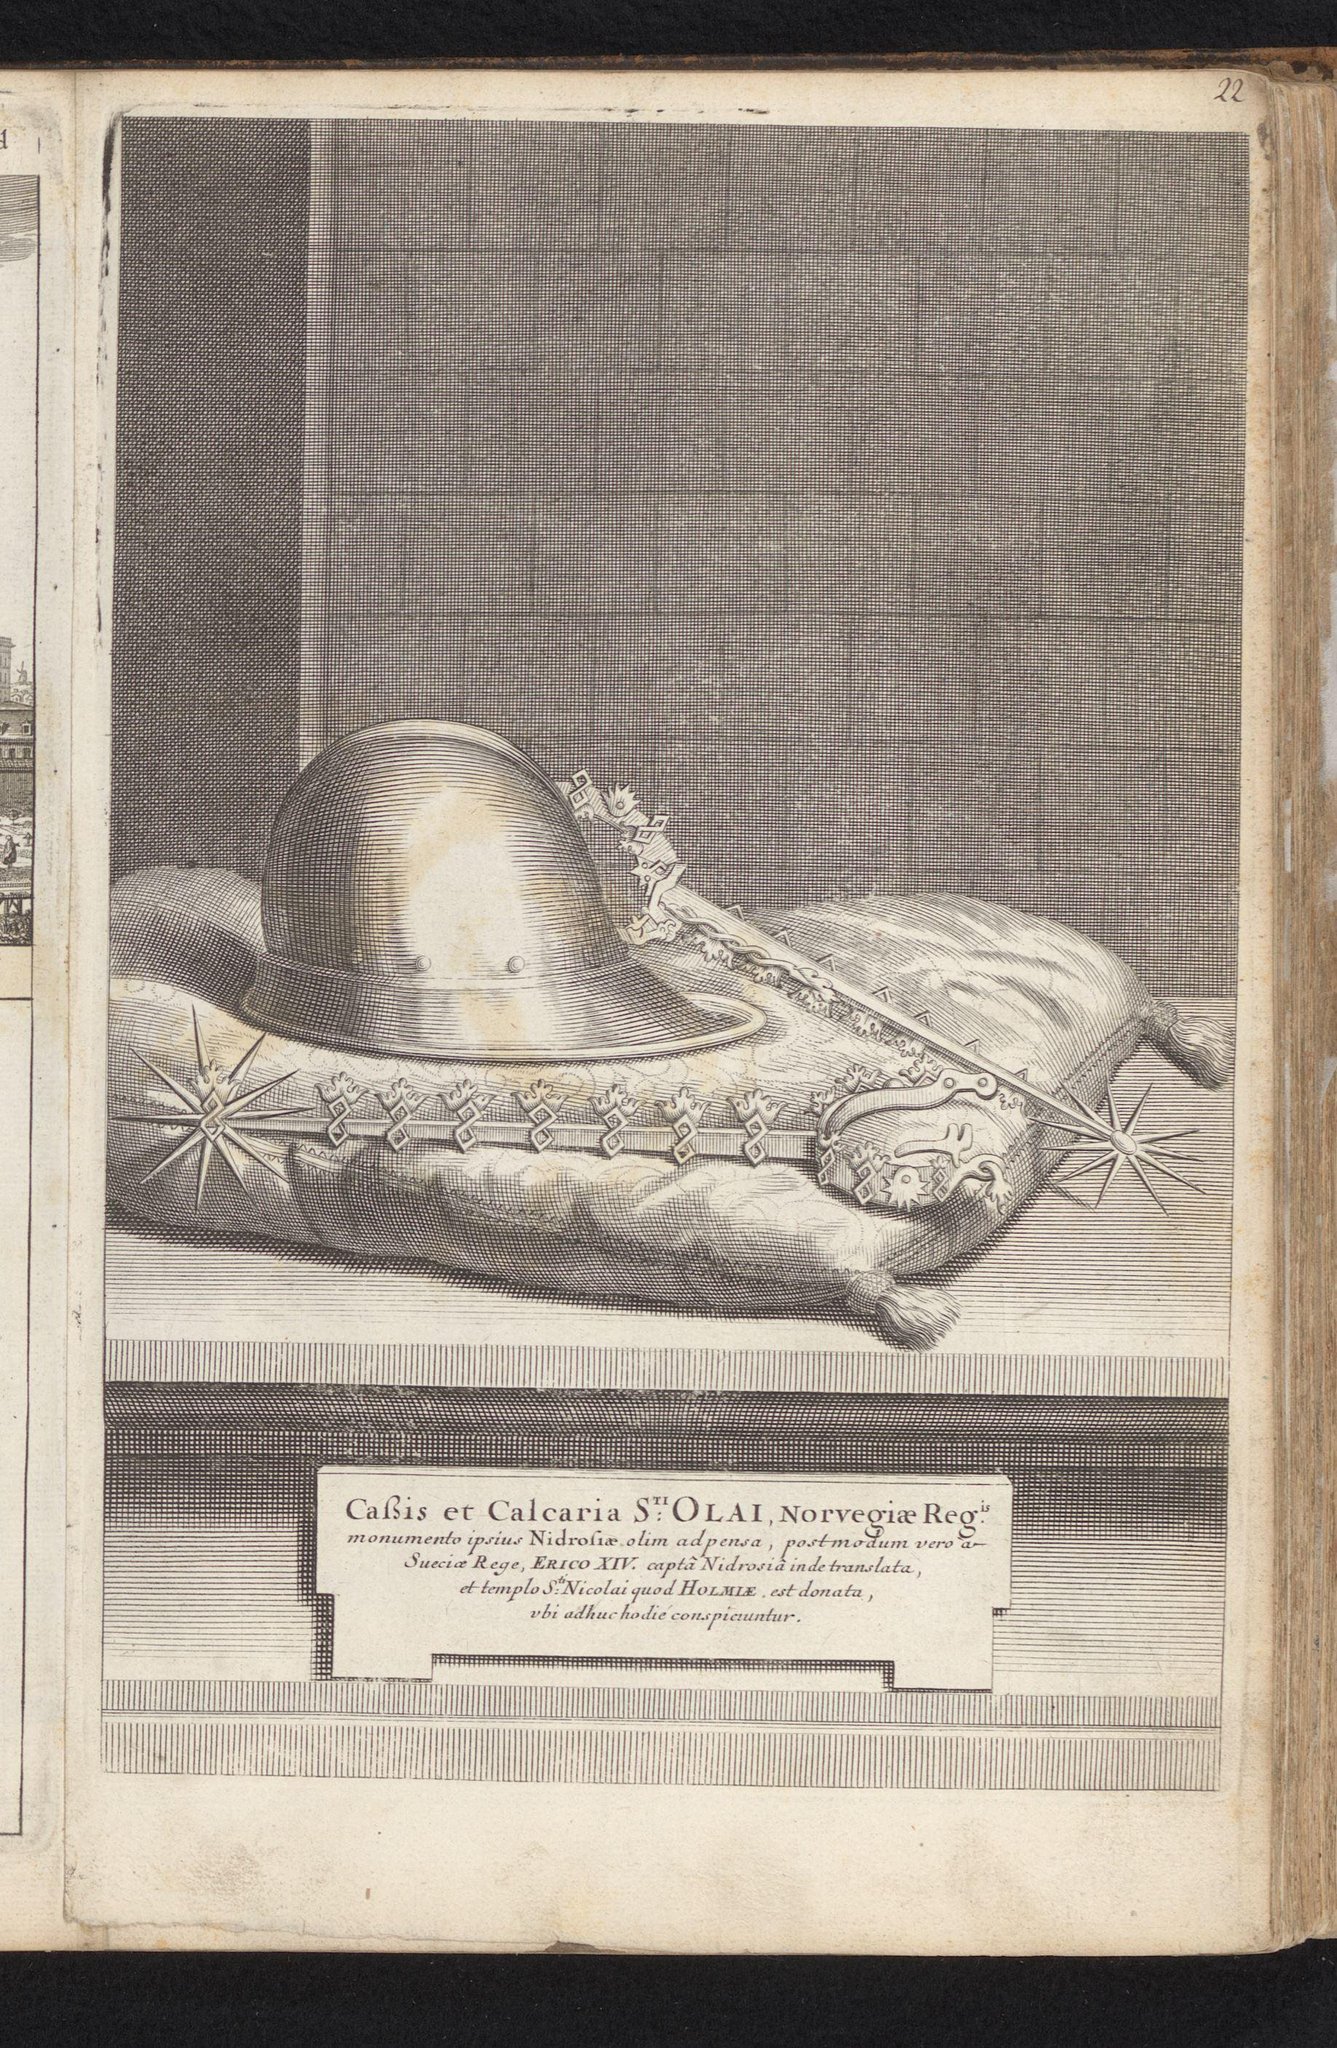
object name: album leaf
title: Helm en sporen van Olaf de Heilige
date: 1669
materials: paper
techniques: engraving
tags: spur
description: Kungliga Biblioteket, 'Suecia': http://www.kb.se/samlingarna/Kartor-bilder/Suecia-antiqua/ (geraadpleegd november 2016).